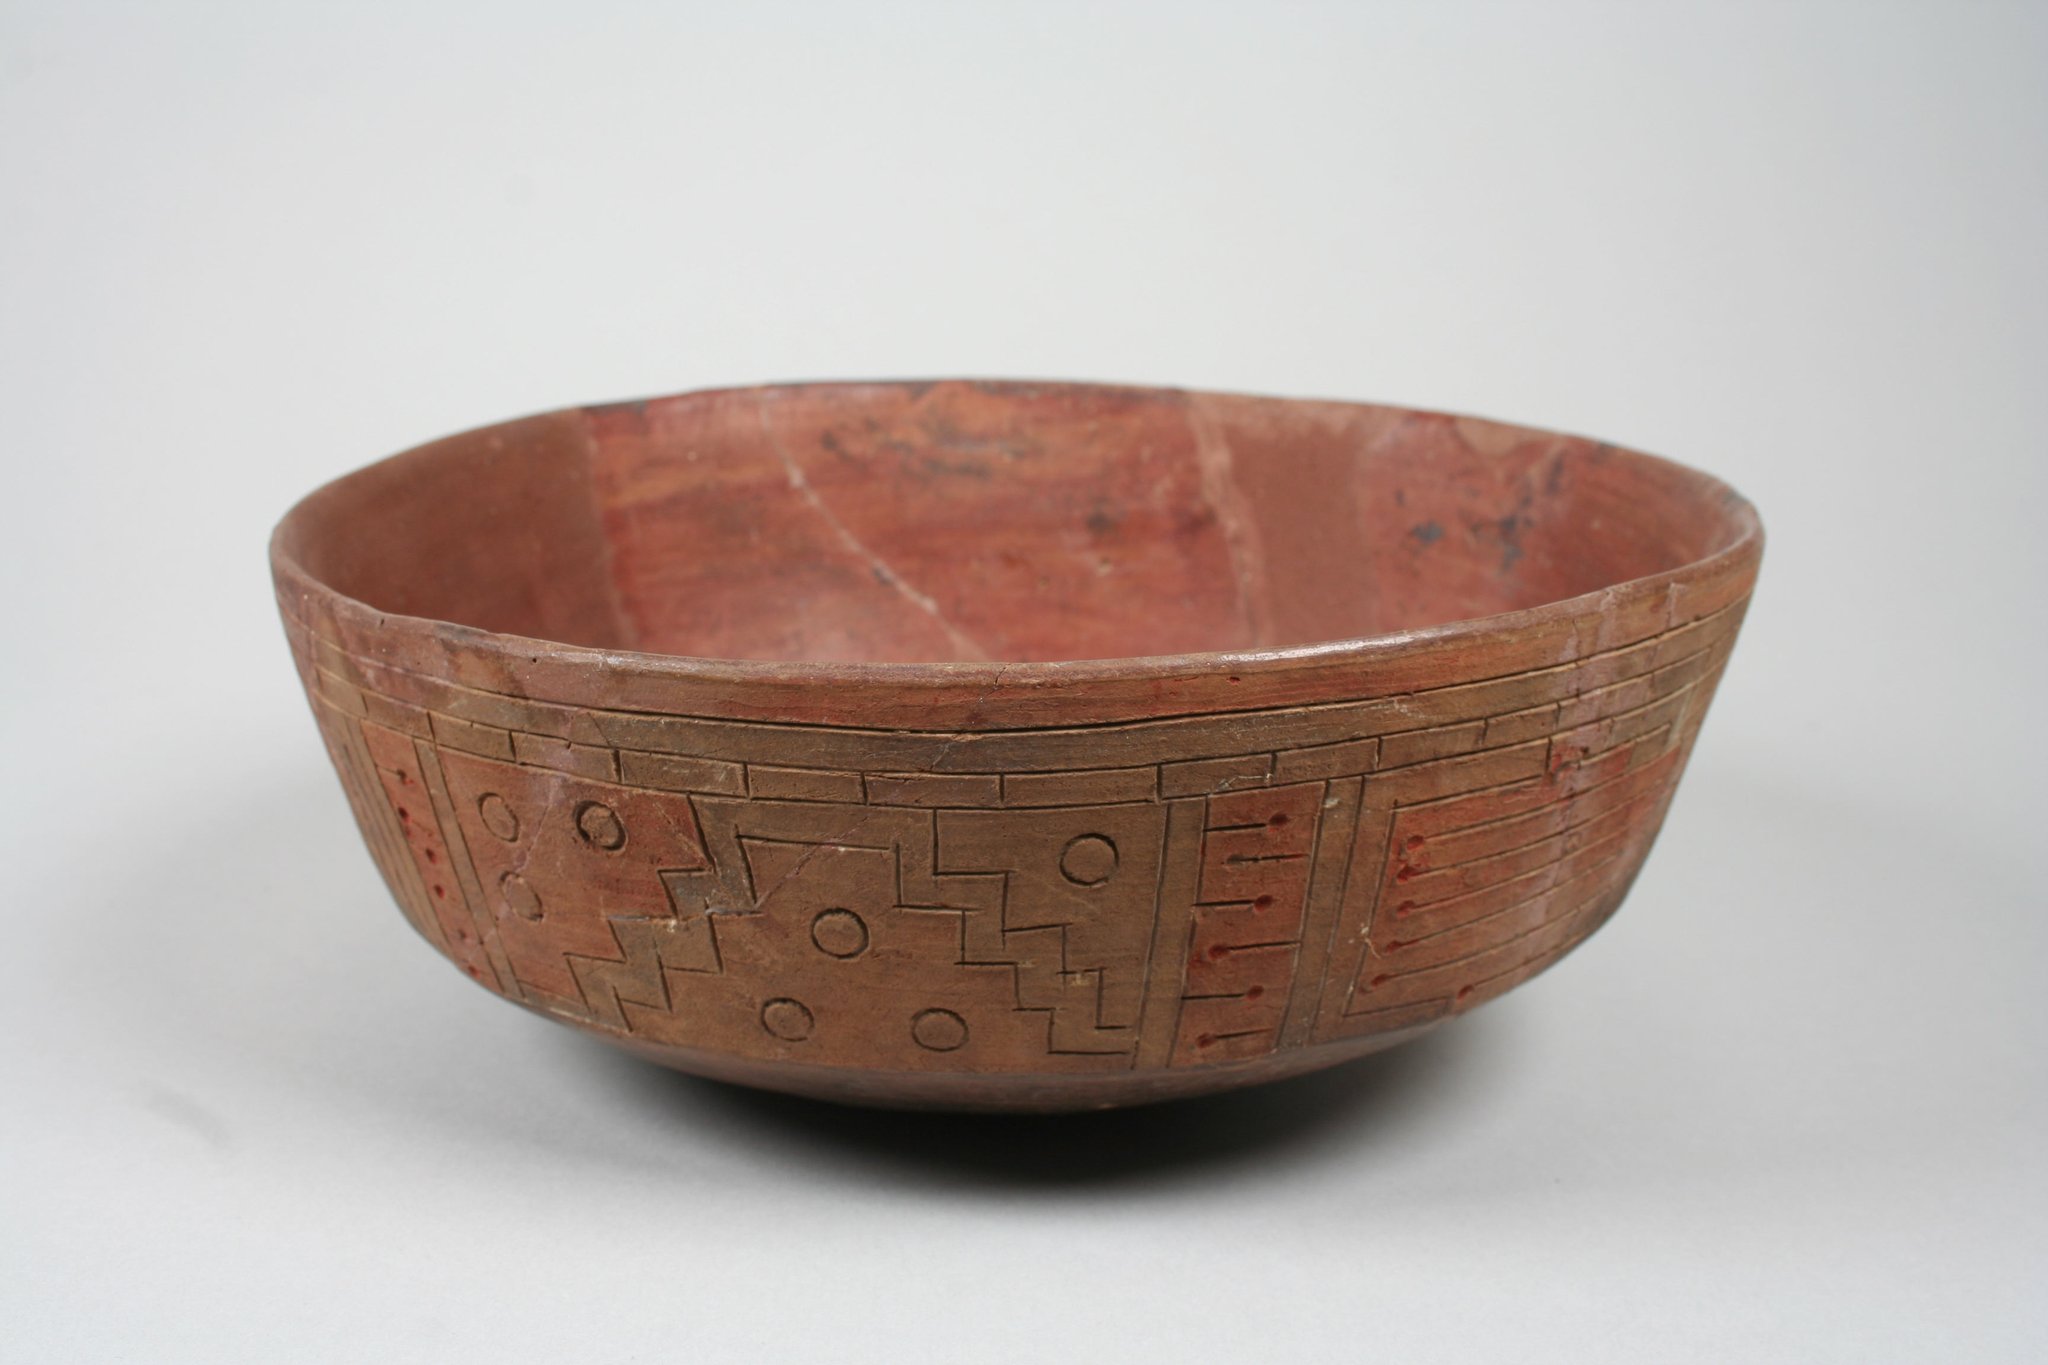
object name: bowl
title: Incised bowl with geometric pattern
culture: paracas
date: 500-201 BCE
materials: ceramic, pigment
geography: peru